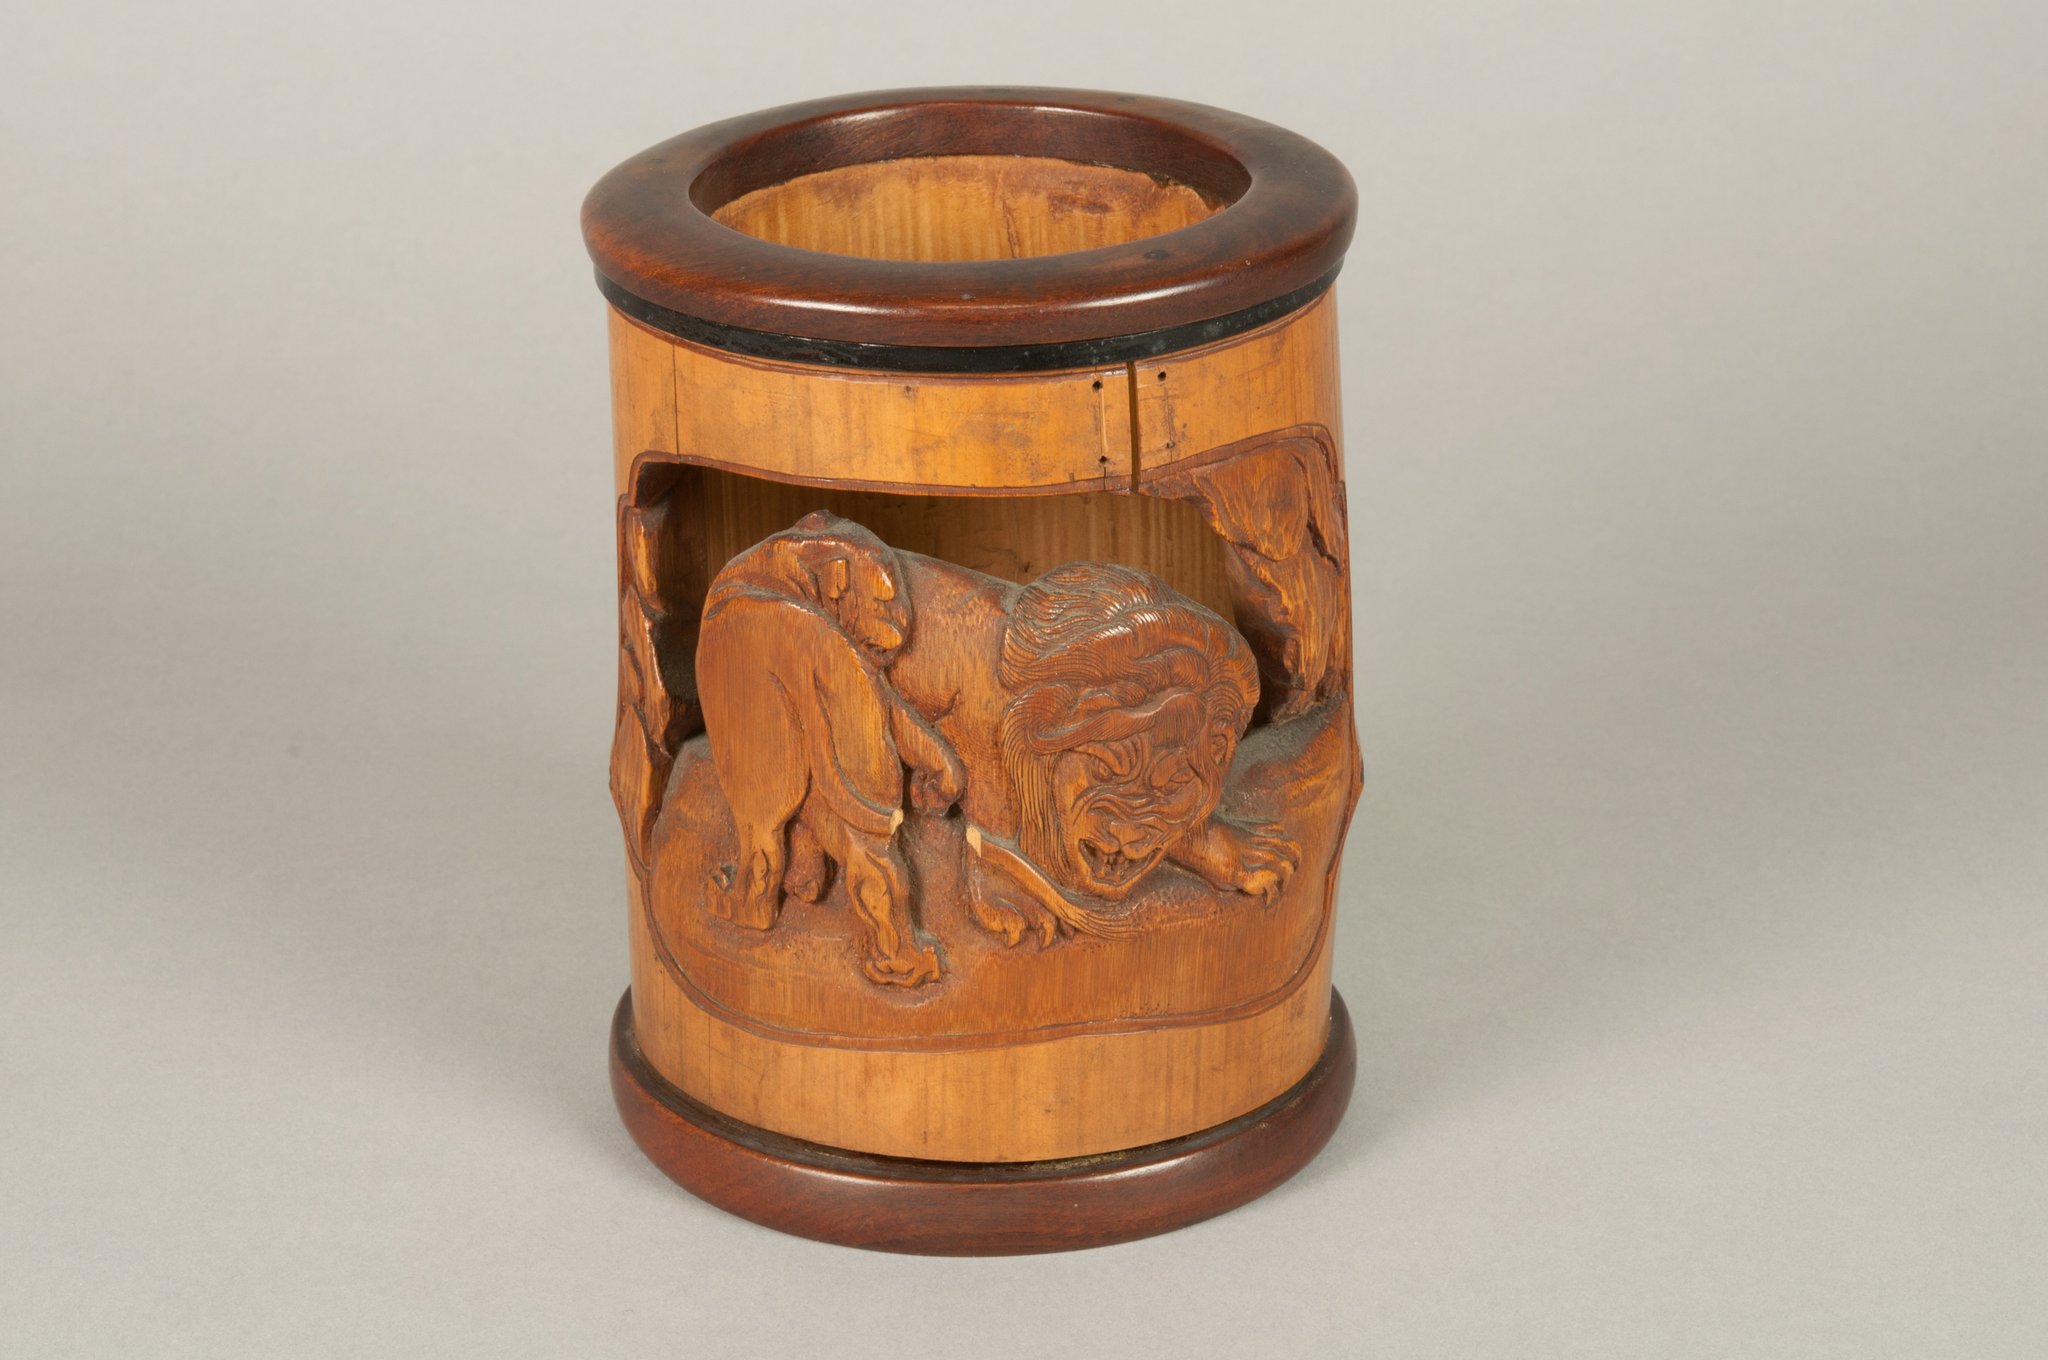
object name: brush holder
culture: japanese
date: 1801-1900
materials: bamboo, lacquer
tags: lions